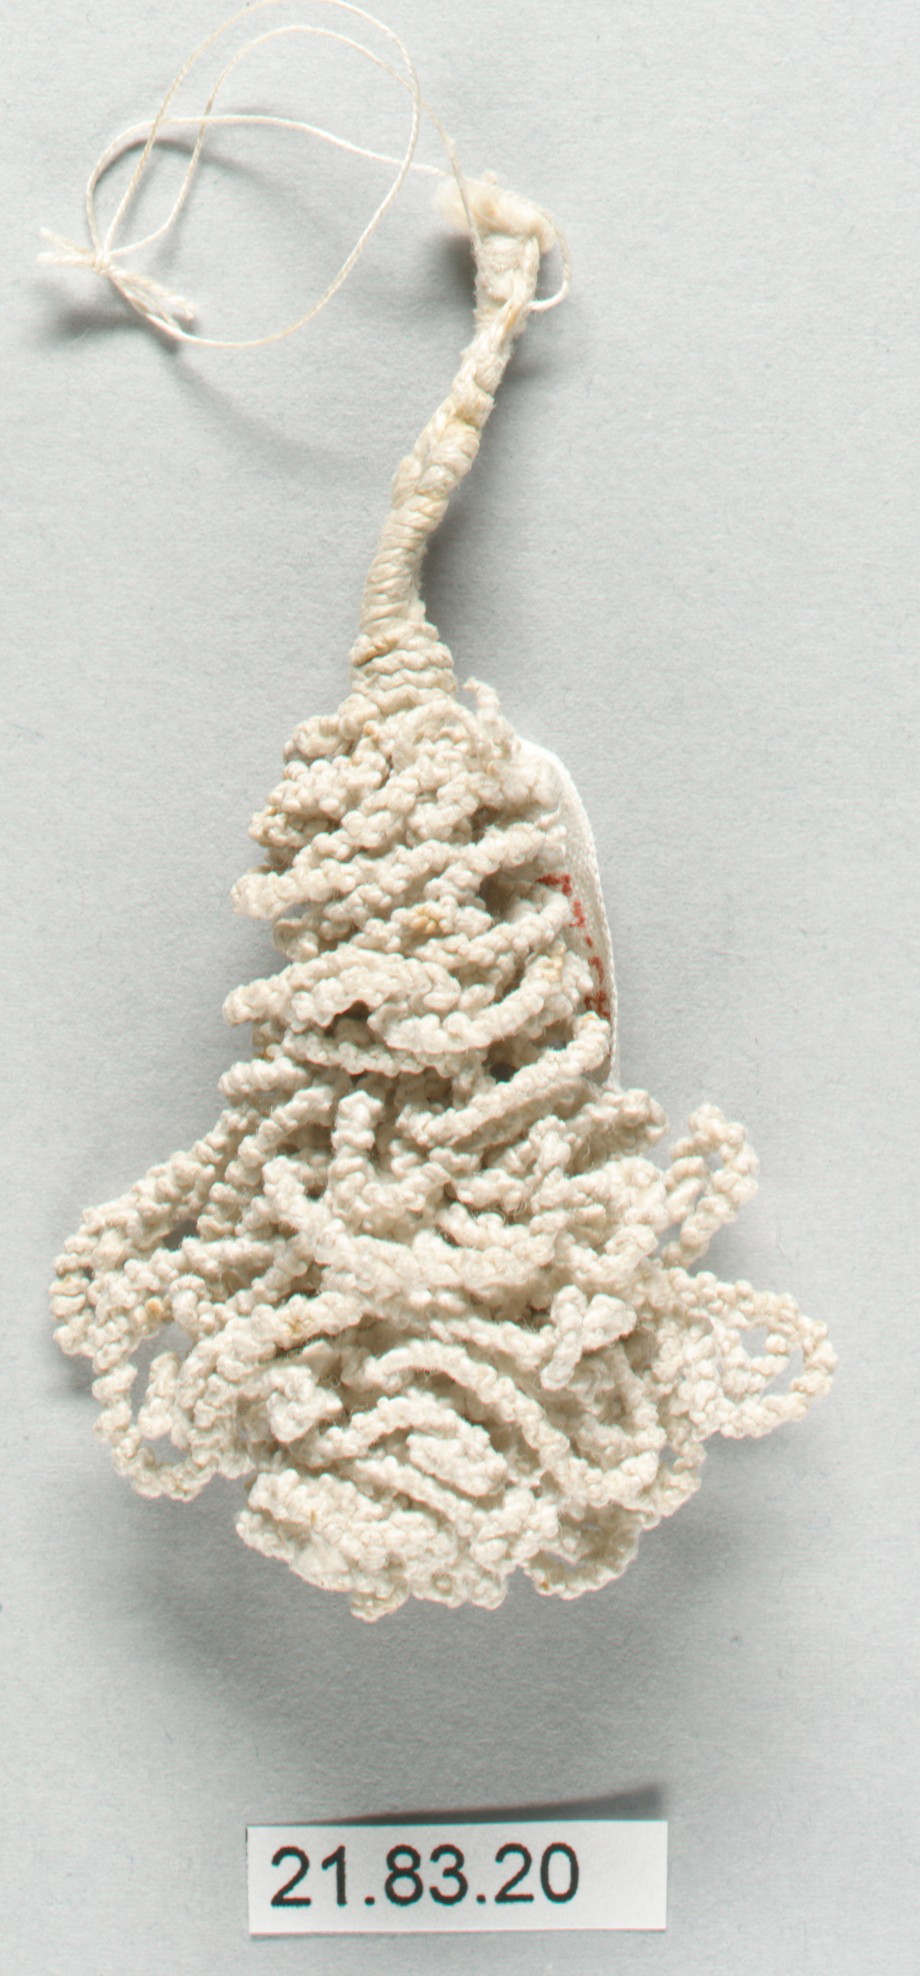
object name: tassel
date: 1601-1700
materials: linen